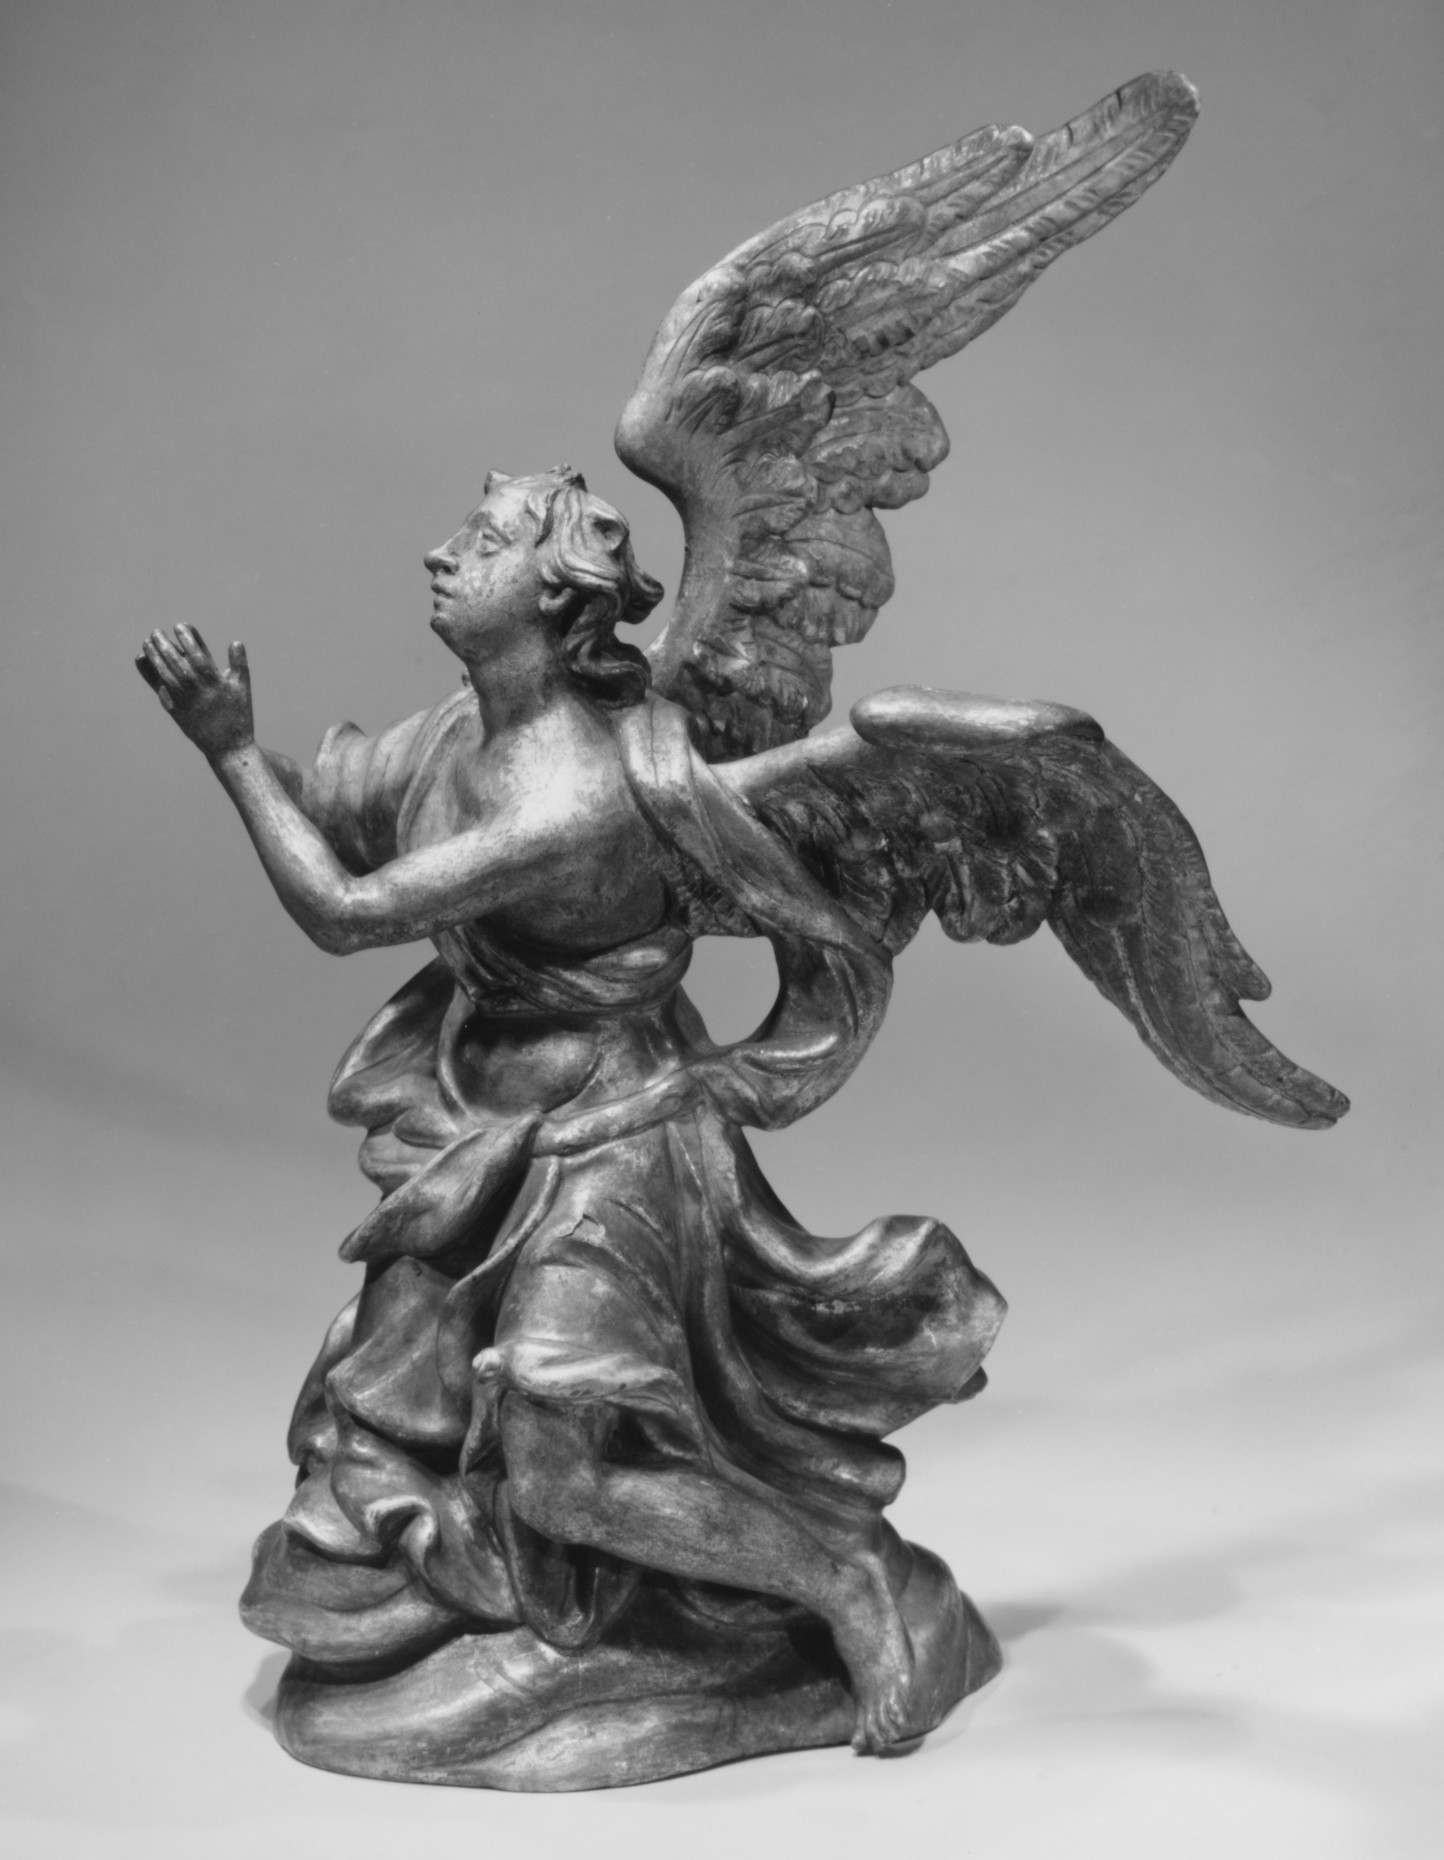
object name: angel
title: Kneeling angel (one of a pair)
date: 1734-1766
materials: gilt, wood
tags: angels